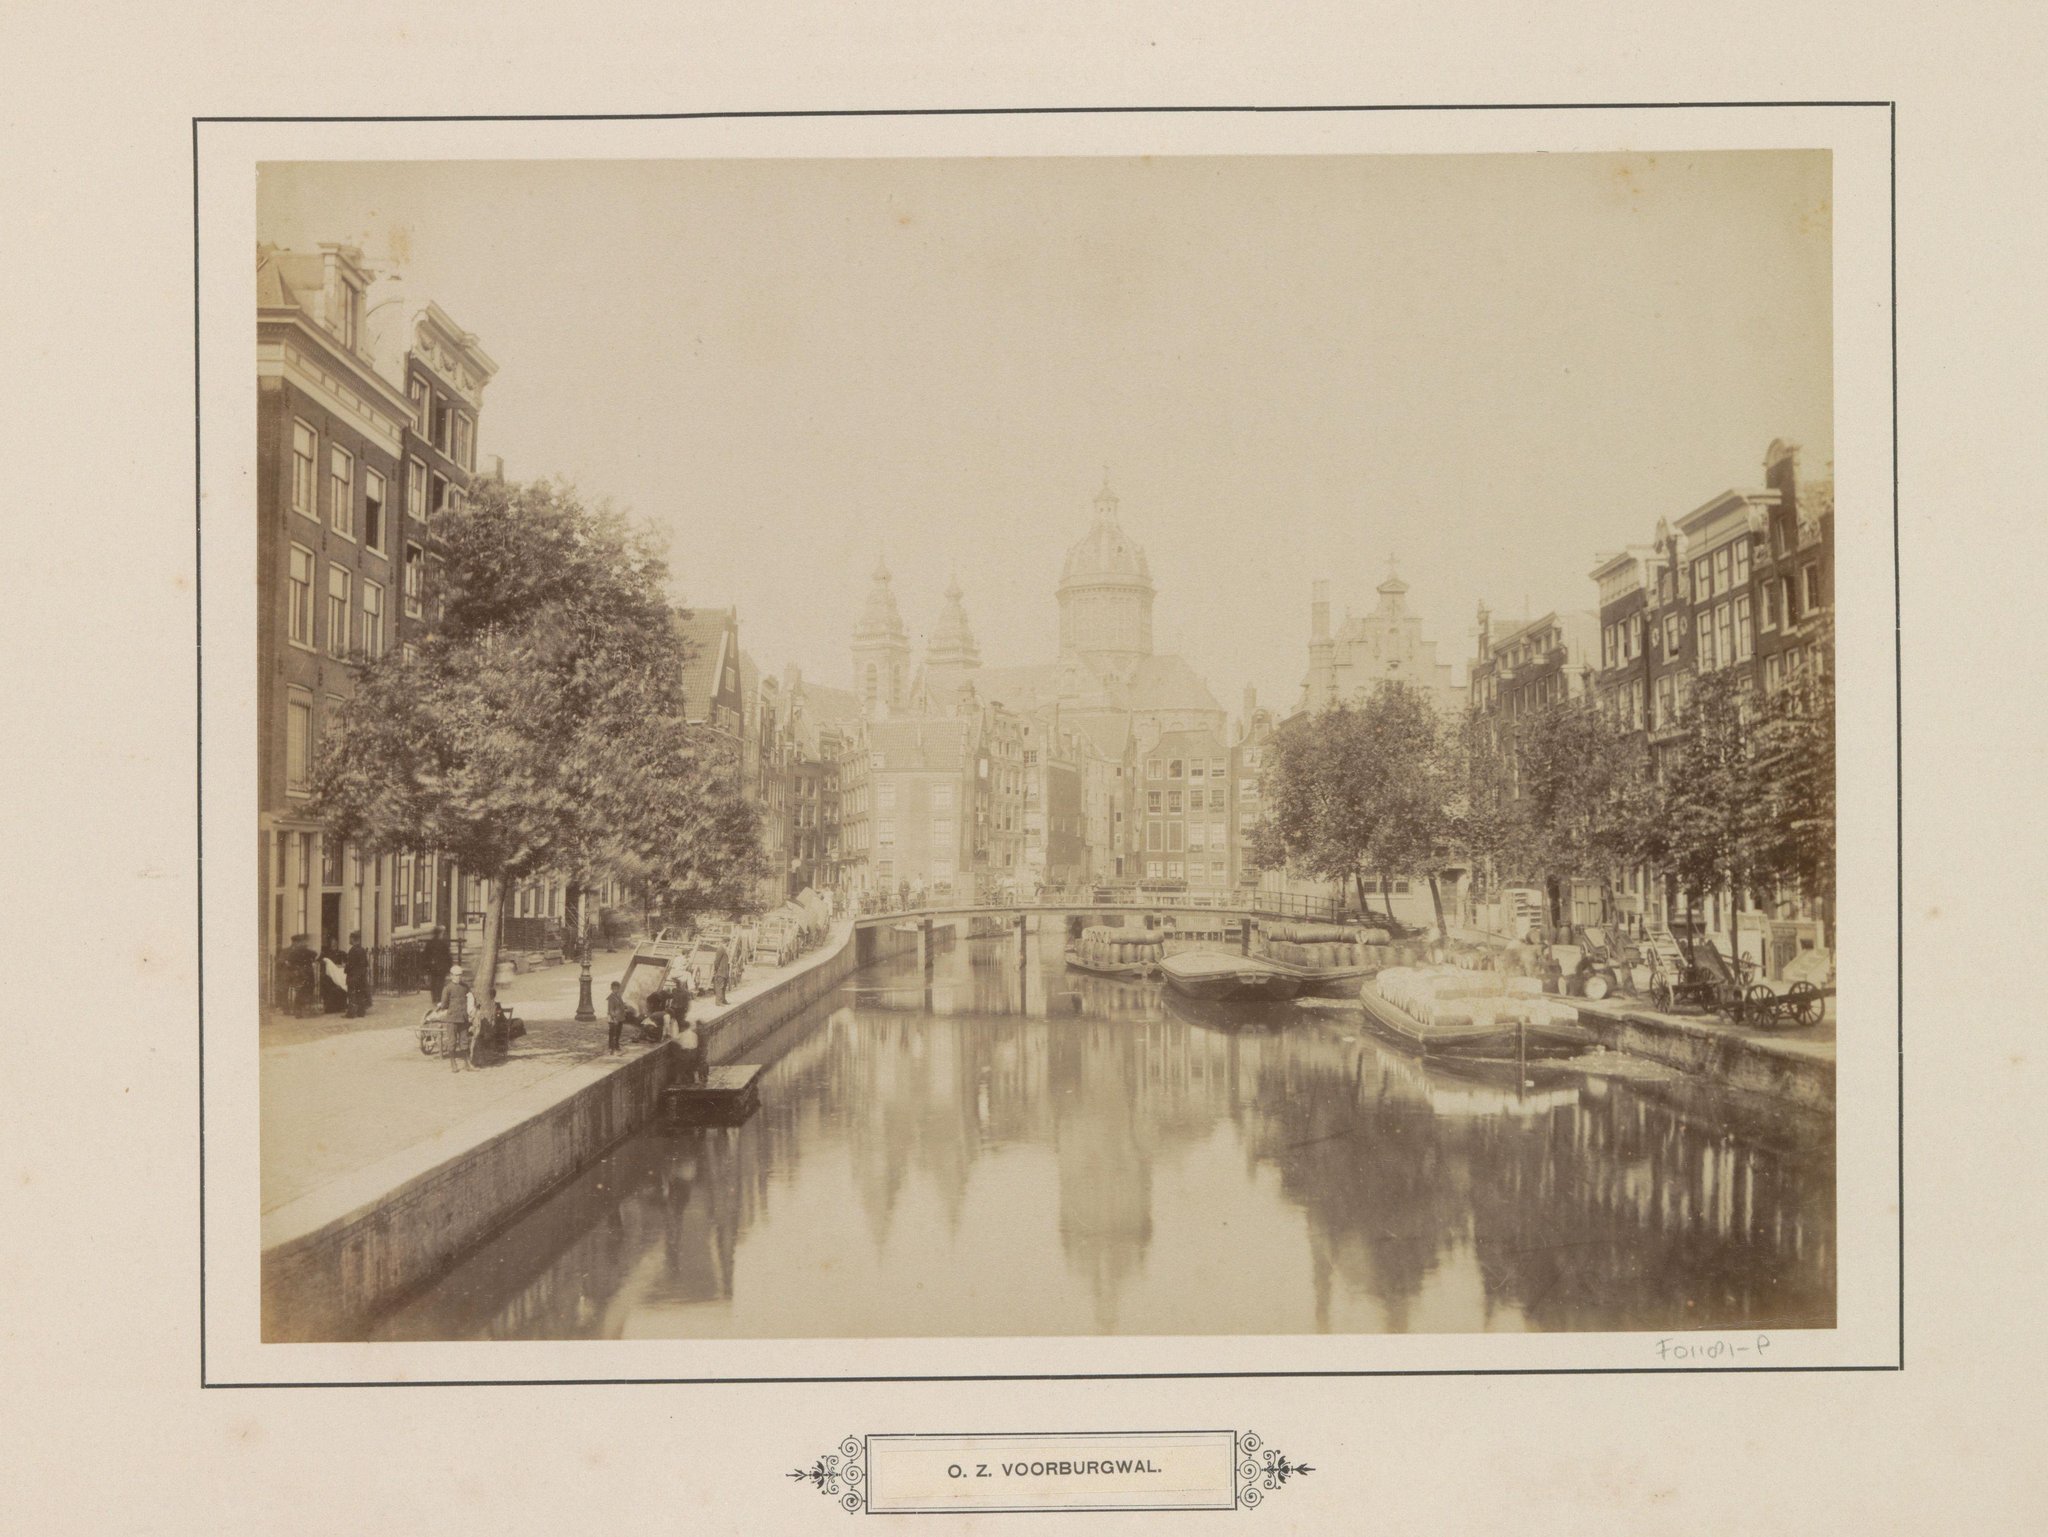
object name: photograph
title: Oudezijds Voorburgwal gezien richting Nicolaaskerk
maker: Anonymous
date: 1880-1895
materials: photographic support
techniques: albumen print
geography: amsterdam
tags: canal, bridge in city across river, canal, etc.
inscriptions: inscription: ‘Hendrik Groote. 43. Kalverstraat 43. Eastman Kodak Agency Darkroom at disposal.’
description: Onderdeel van Fotoalbum met opnames van het centrum van Amsterdam en reclameteksten voor winkels en bedrijven.